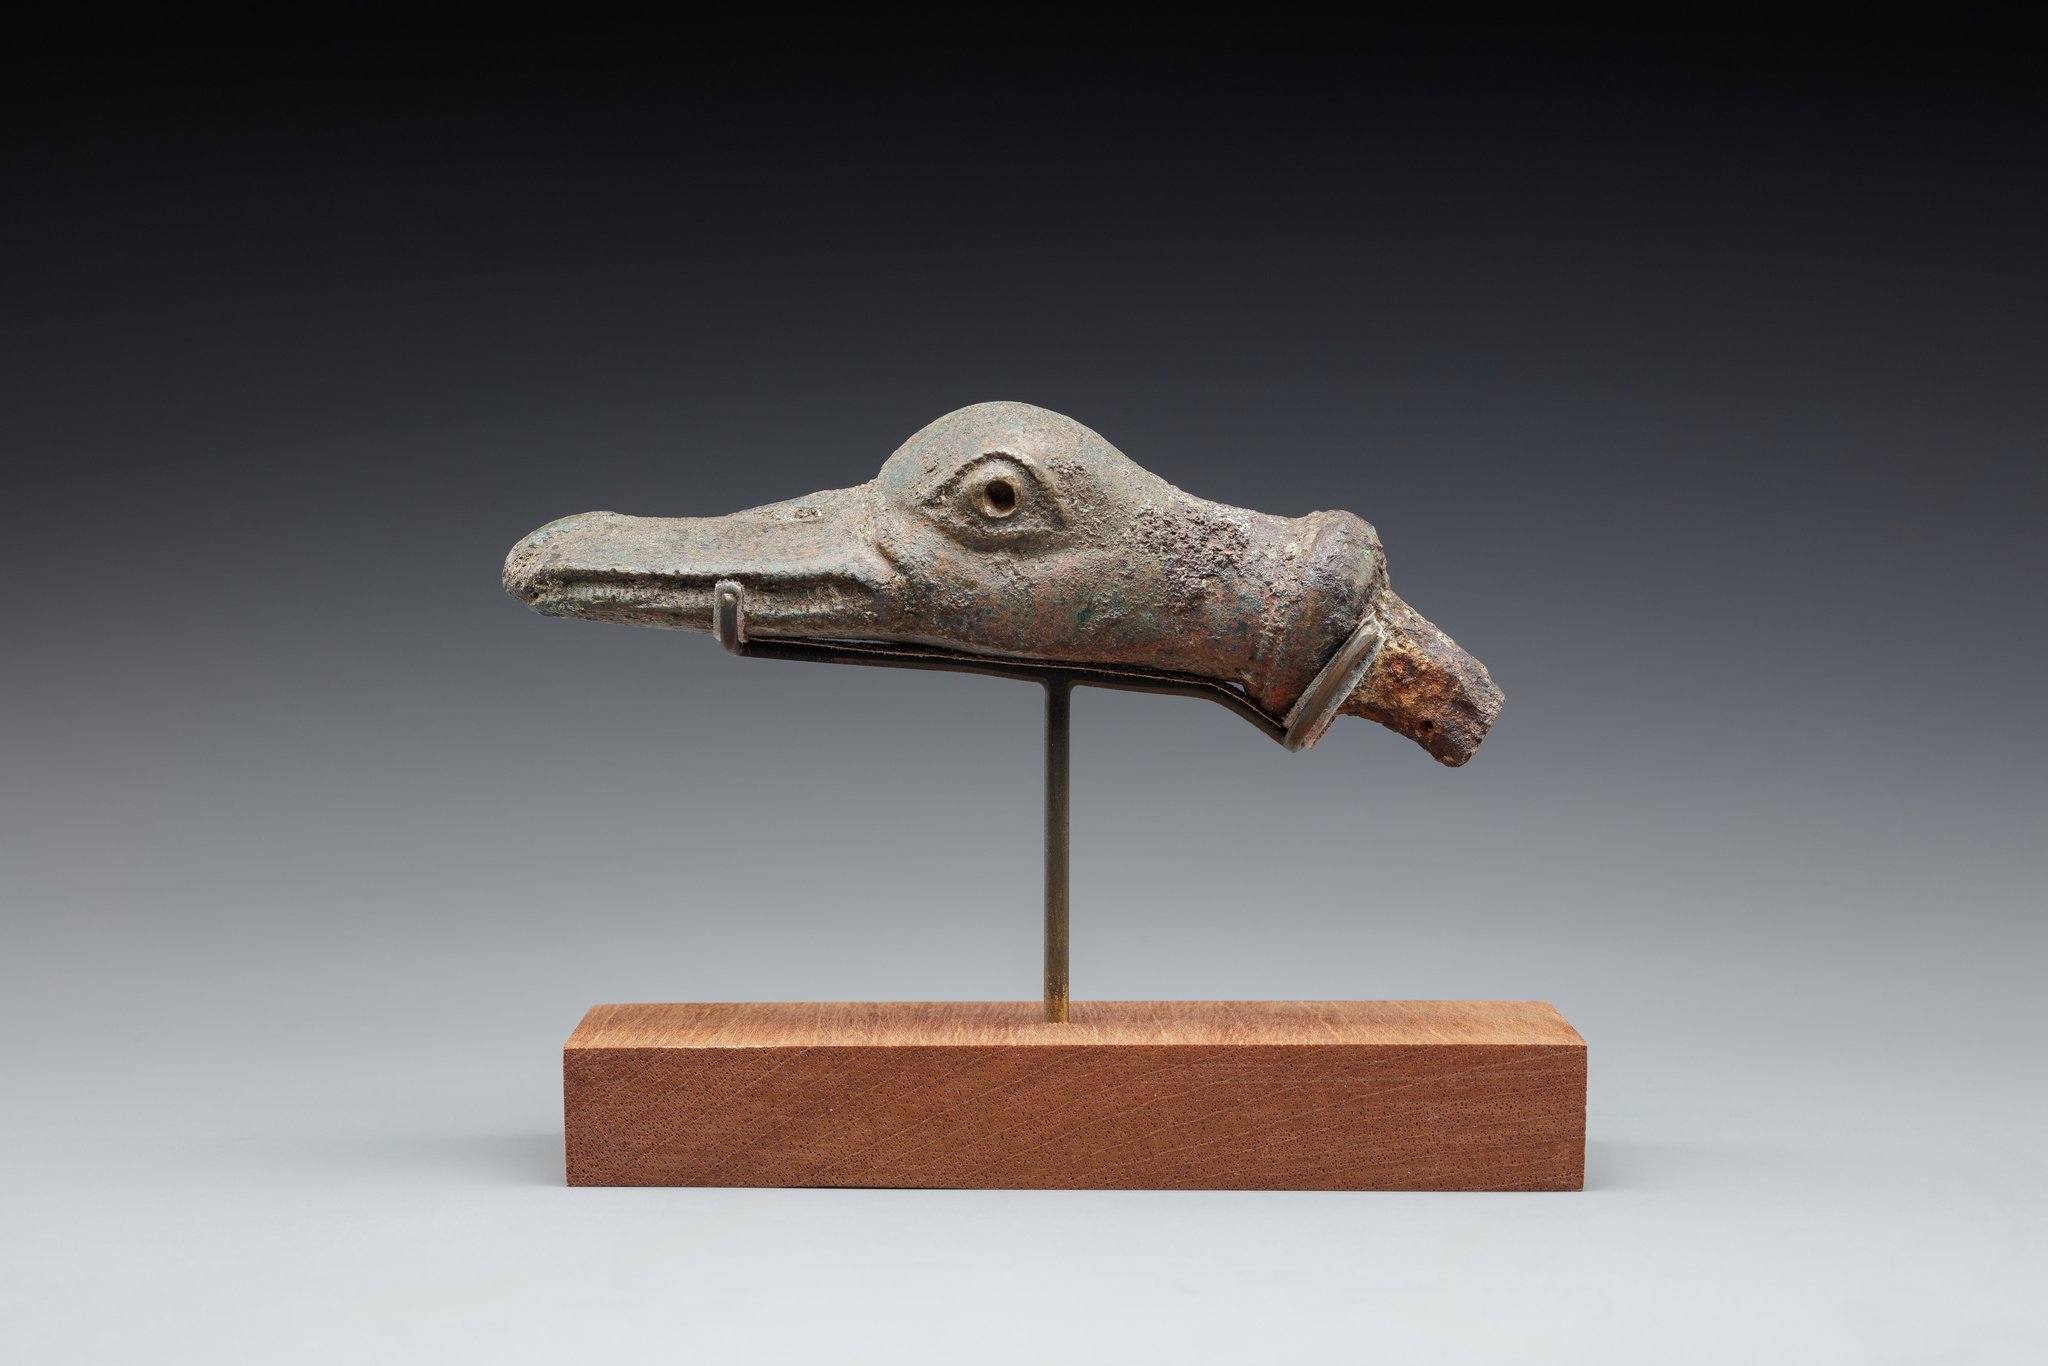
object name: attachment, duck's head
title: Duck's head with tenon attachment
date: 715-332 BCE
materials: bronze, copper alloy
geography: middle egypt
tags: ducks